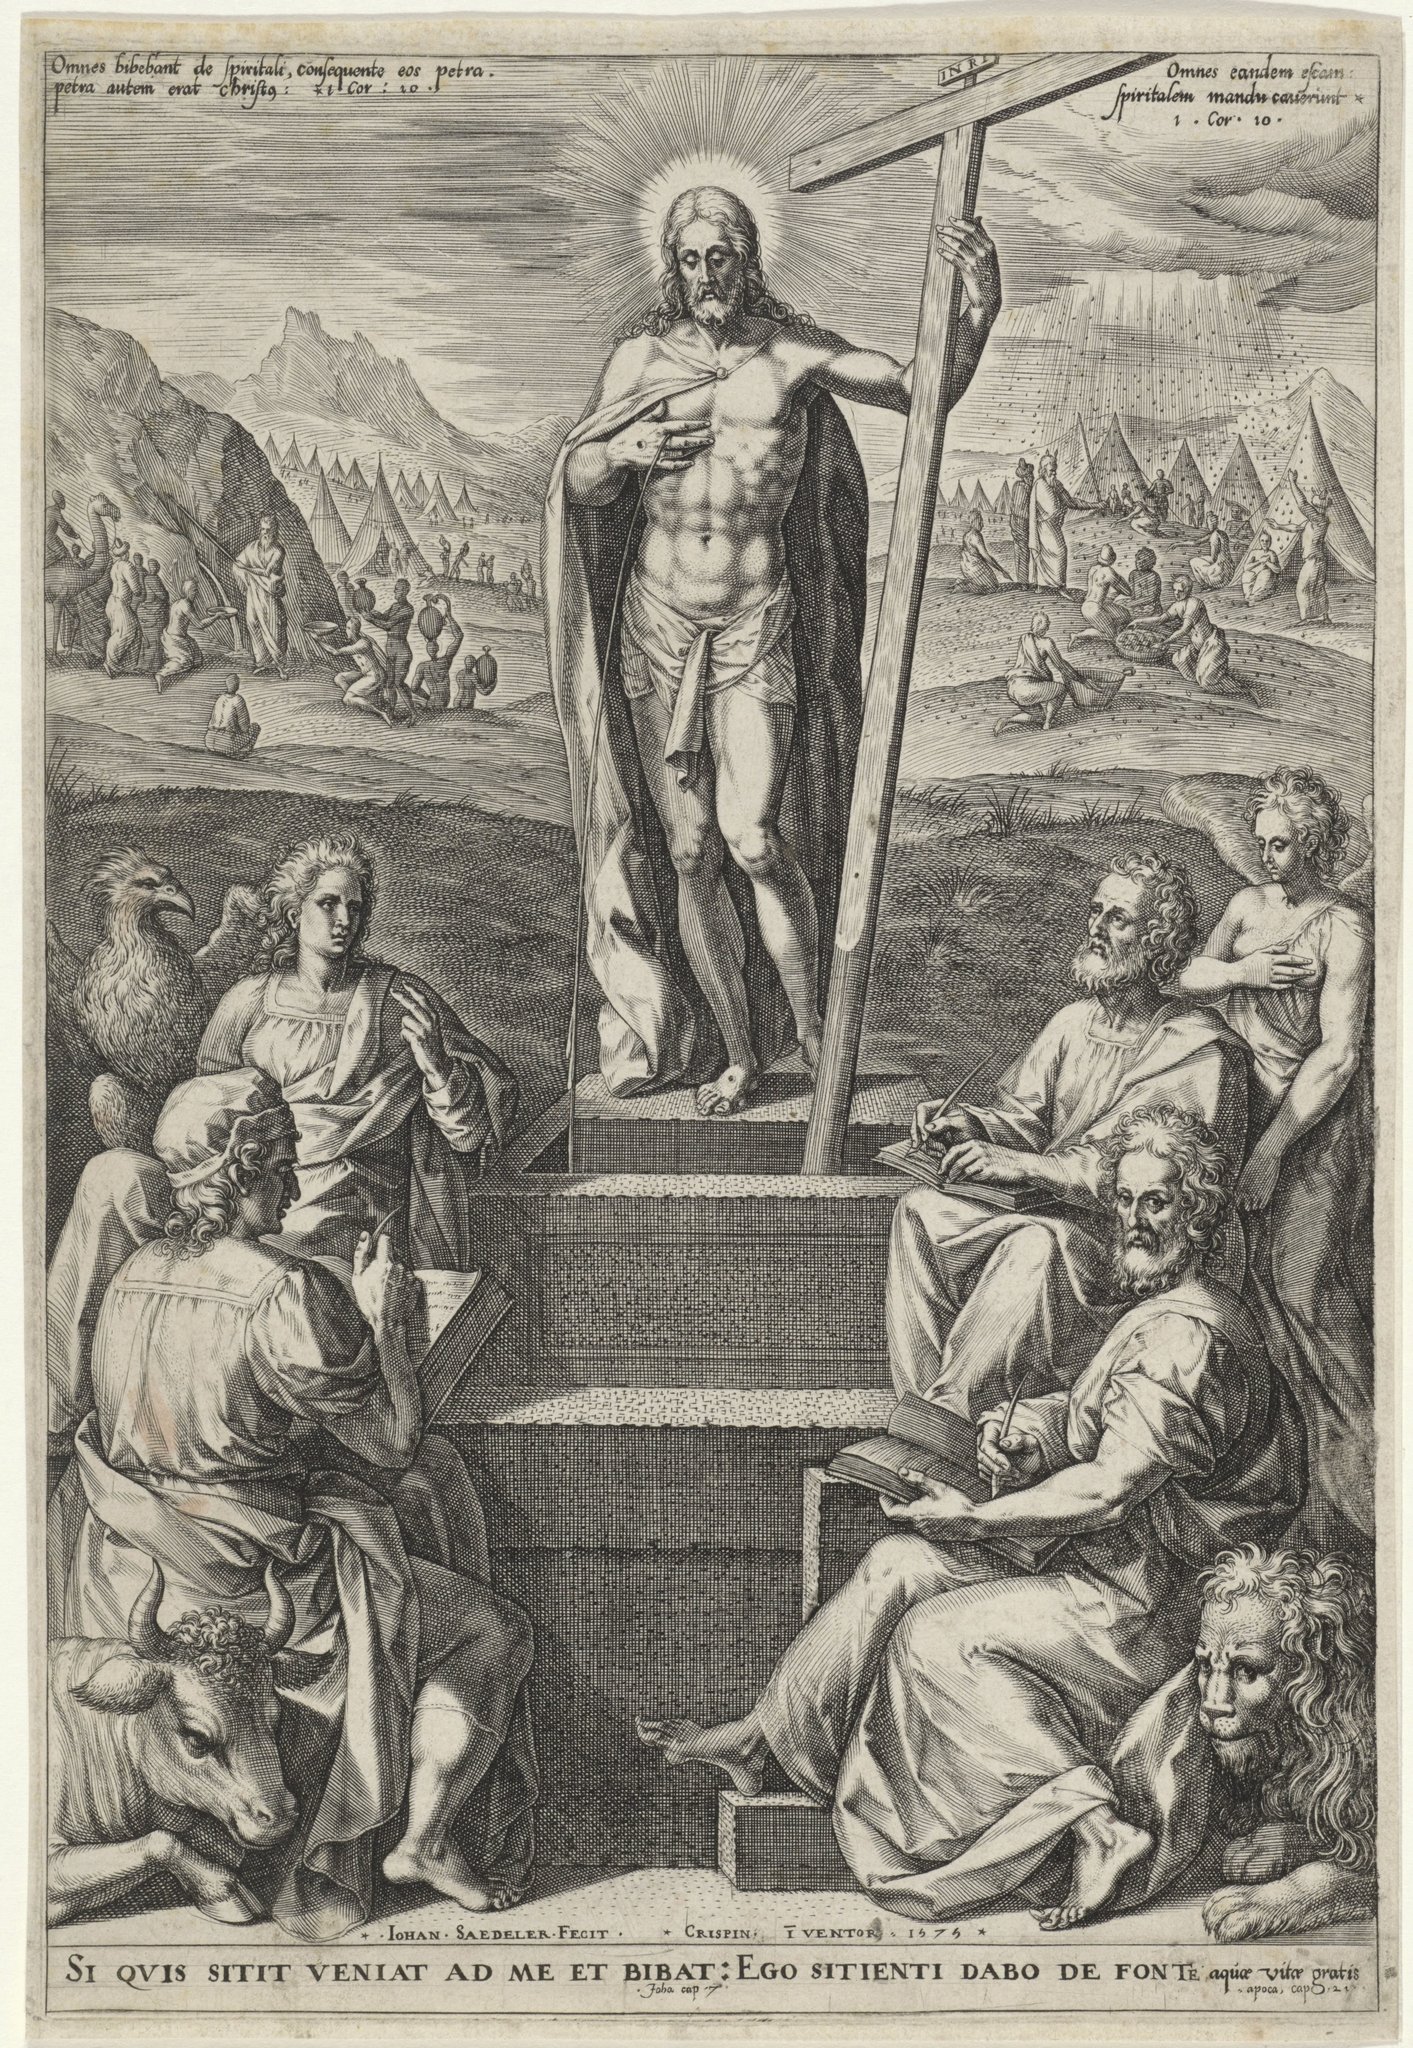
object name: print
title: Christus als fontein des levens (Fons Vitae)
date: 1575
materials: paper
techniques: engraving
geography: antwerp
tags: evangelists, usually with books or scrolls (not in biblical context), in the morning manna falls to the earth ~ exodus, moses striking water from the rock (exodus 17:1-7; numbers 20:2-13), christ standing on or near a fountain, shedding his blood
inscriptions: collector's mark: Lugt 240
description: Christus op een fontein. Hij houdt zijn rechterhand op zijn borst waaruit bloed stroomt in een bekken. Hij is de Fontein van het Leven (Fons vitae) waar de mensheid naar toe komt om zich te laven. Rondom de fontein de vier evangelisten. Op de achtergrond twee scènes uit Exodus. Links slaat Mozes water uit een rots. Rechts regent het manna uit de hemel.